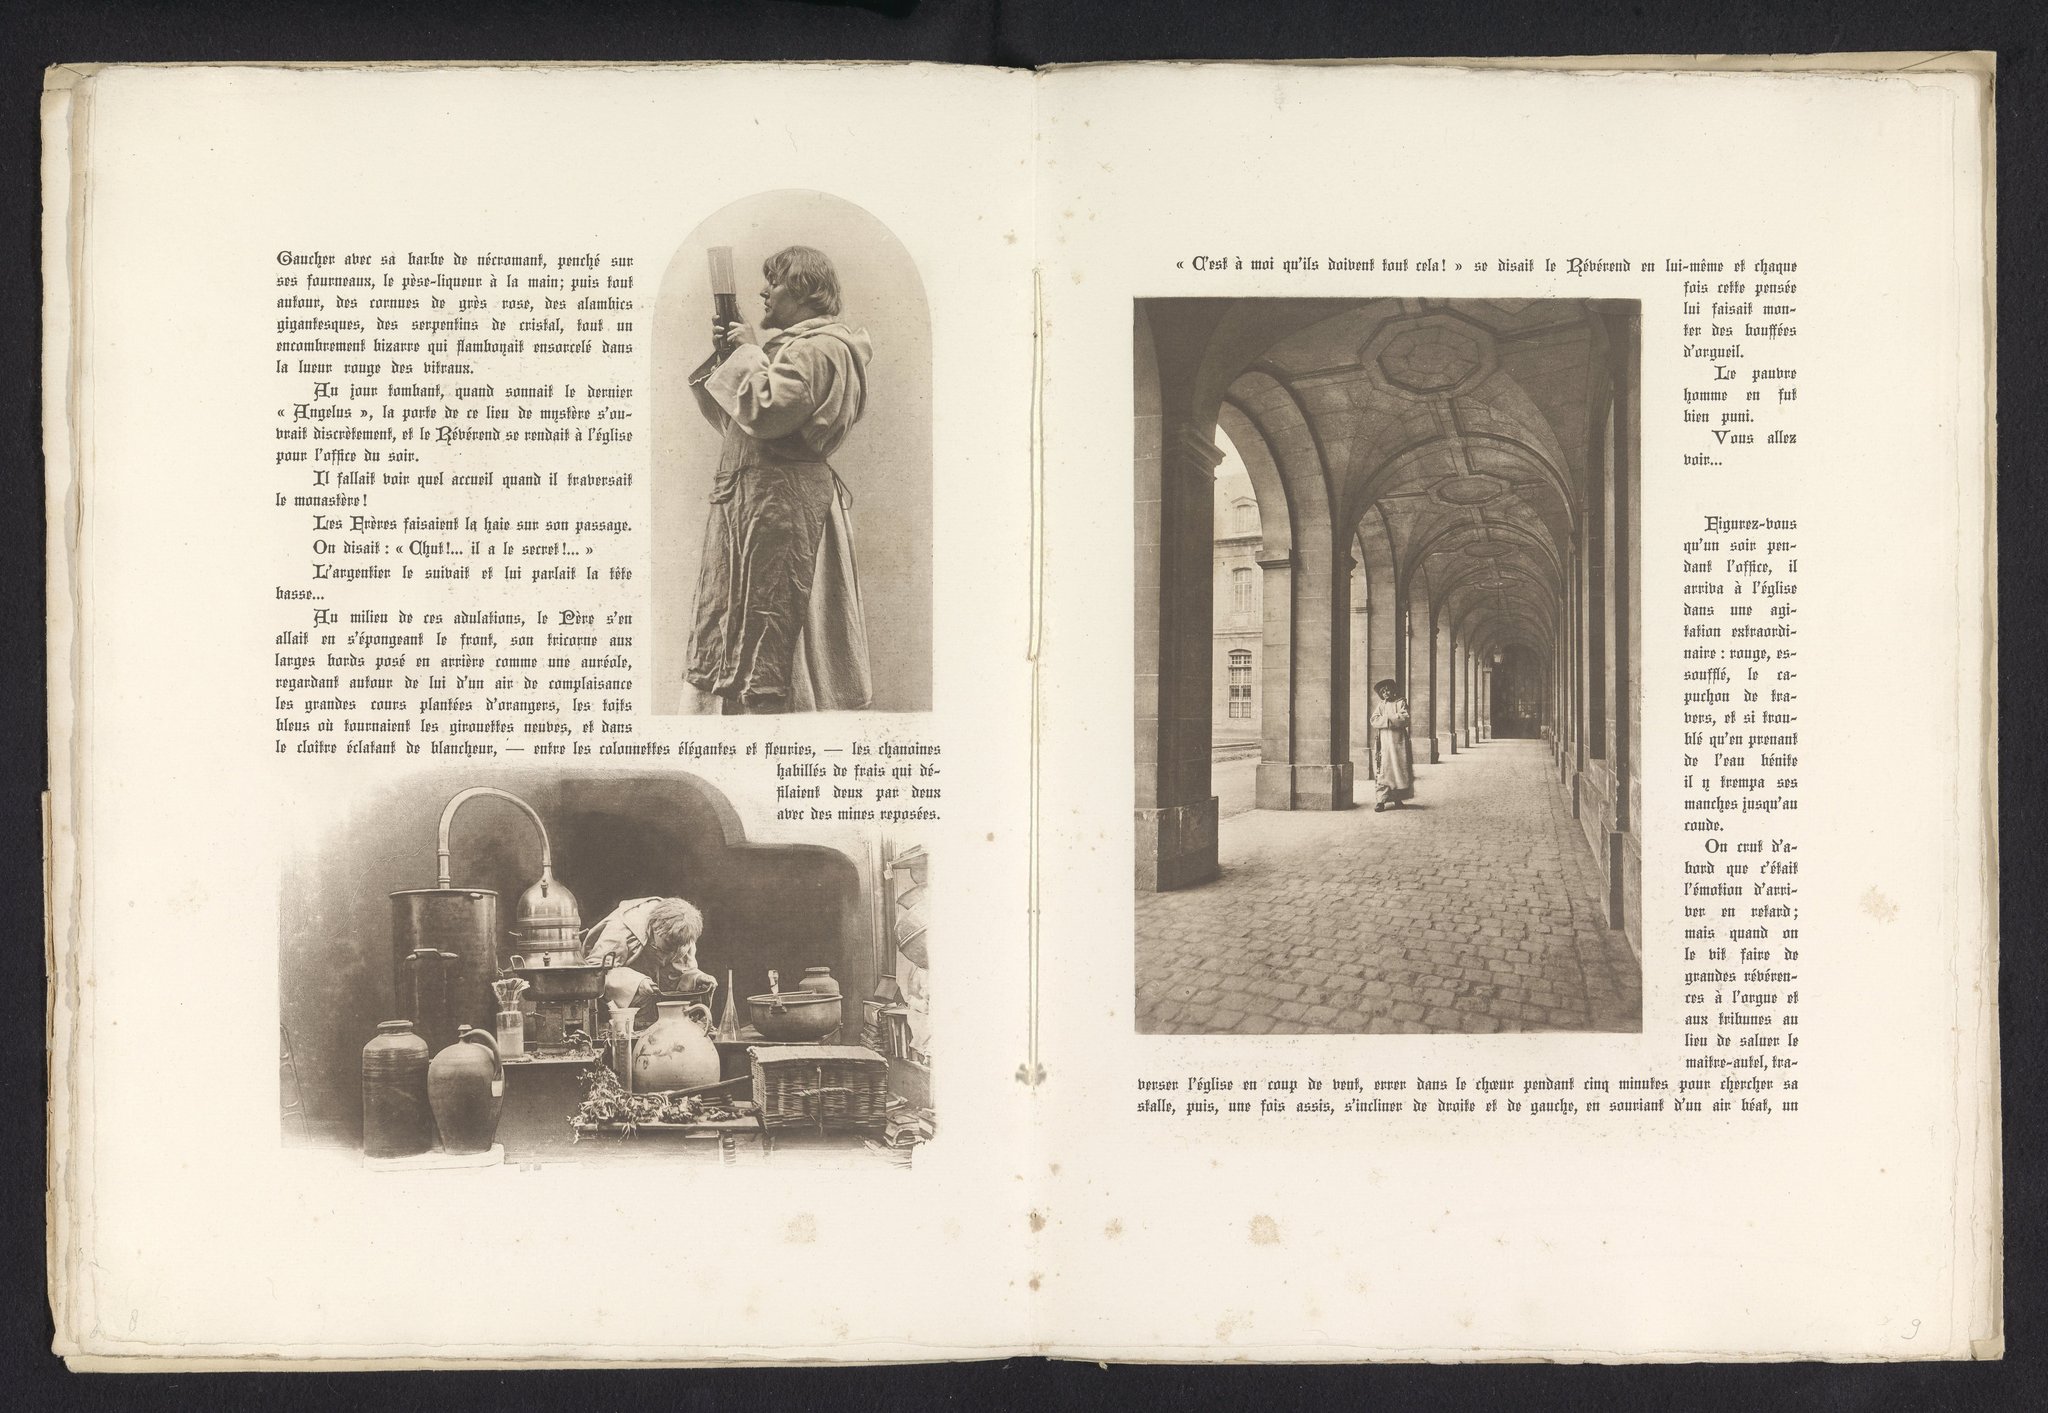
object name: photomechanical print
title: Monnik met een boek en een monnik naast een brouwinstallatie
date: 1885-1896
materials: paper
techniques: photoaquatint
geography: france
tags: daily activities in convent, e.g. brewing, writing, monk(s), friar(s)